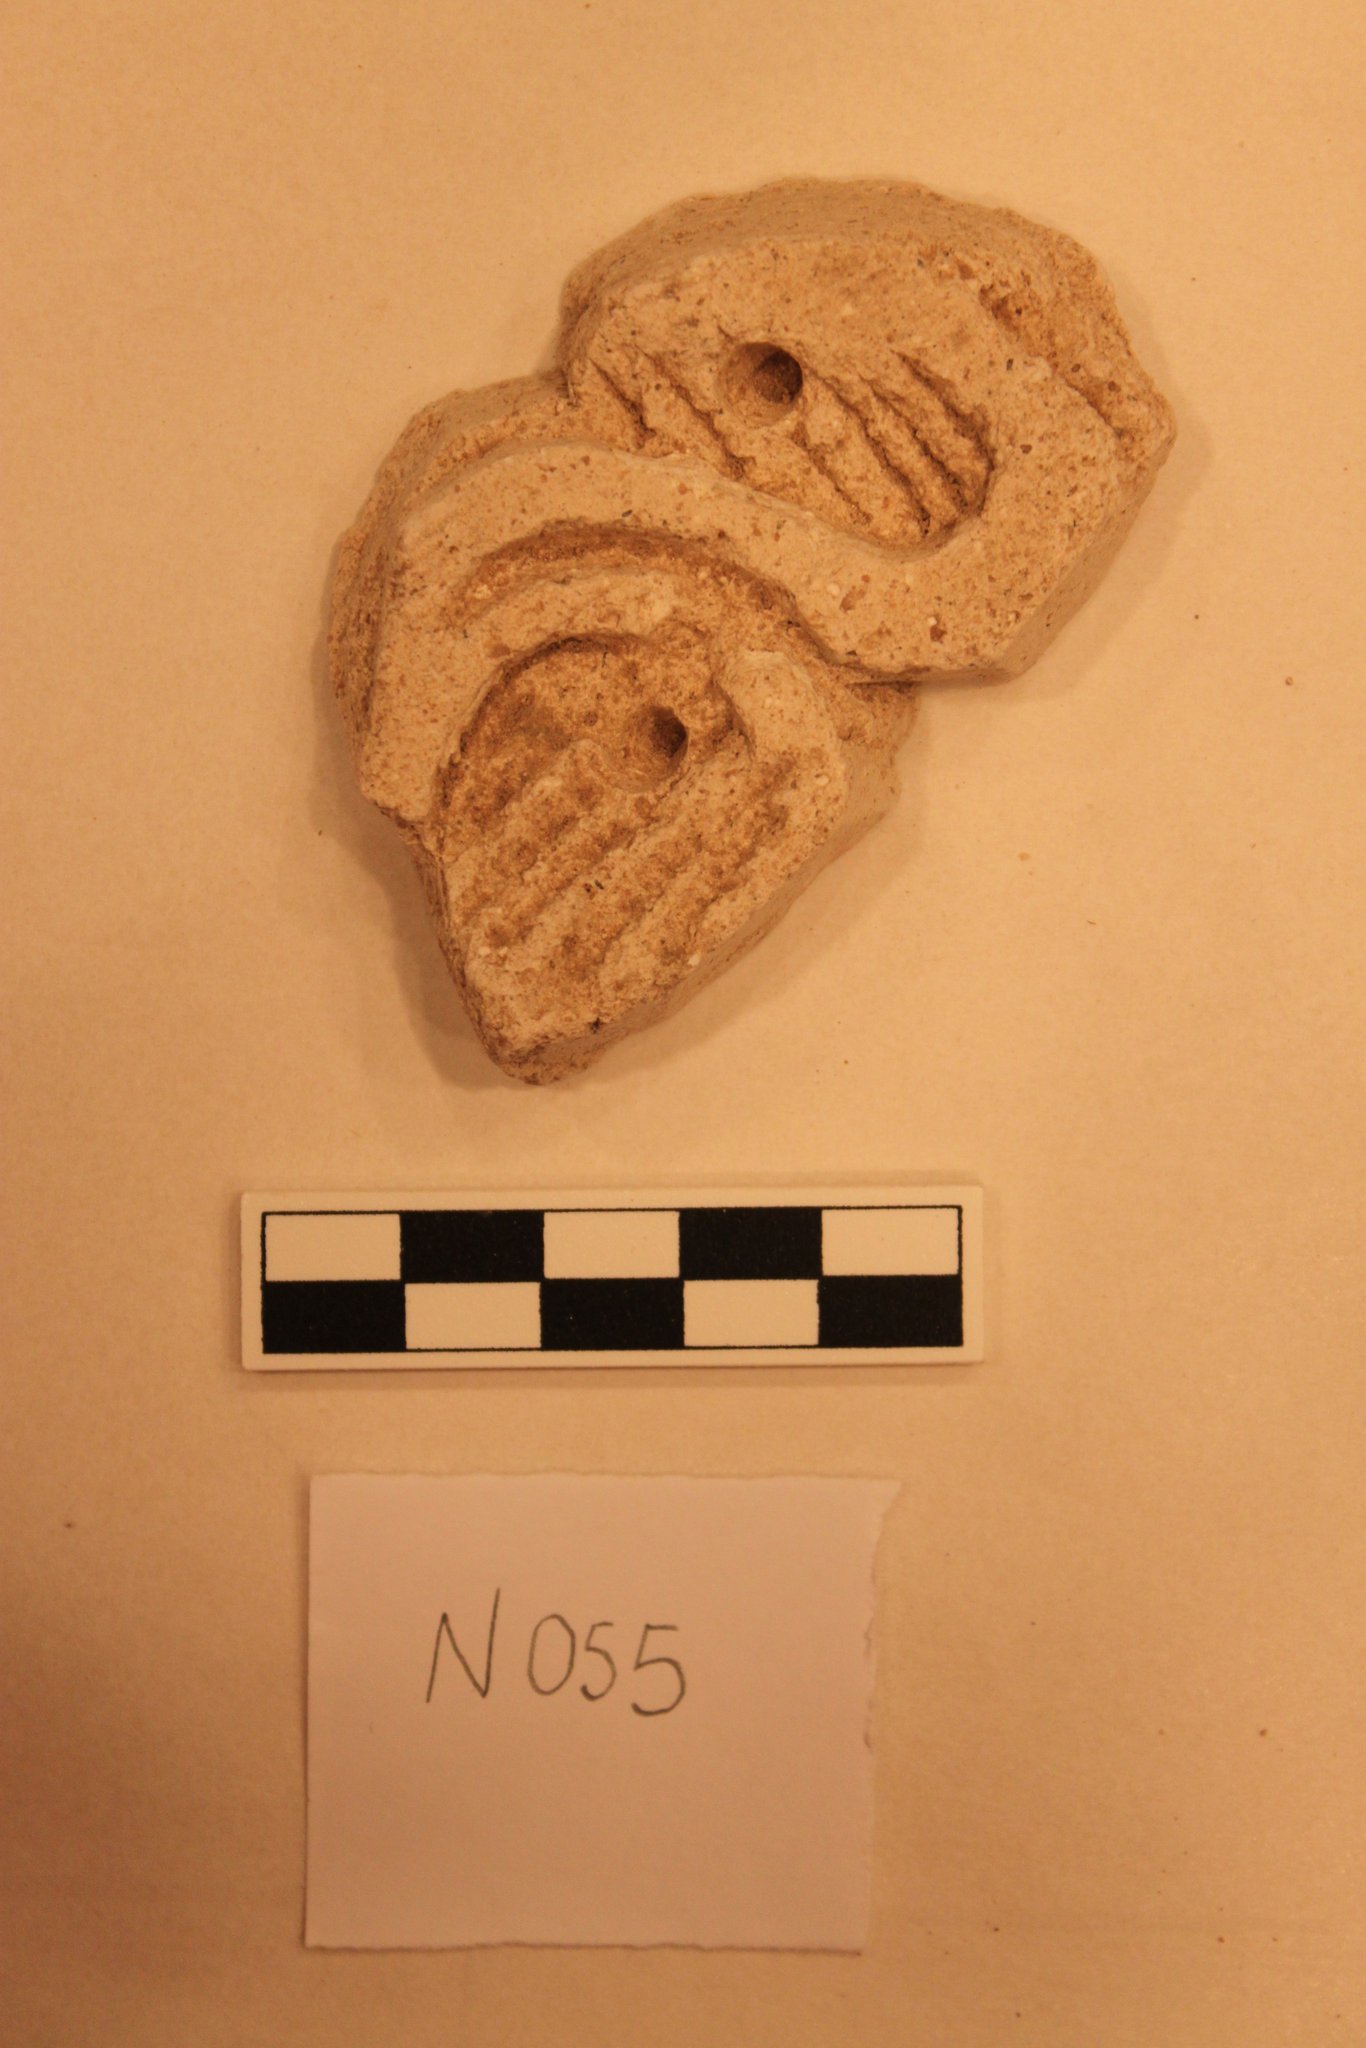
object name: fragment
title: Stucco Fragment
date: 701-1200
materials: plaster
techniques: carving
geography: iran